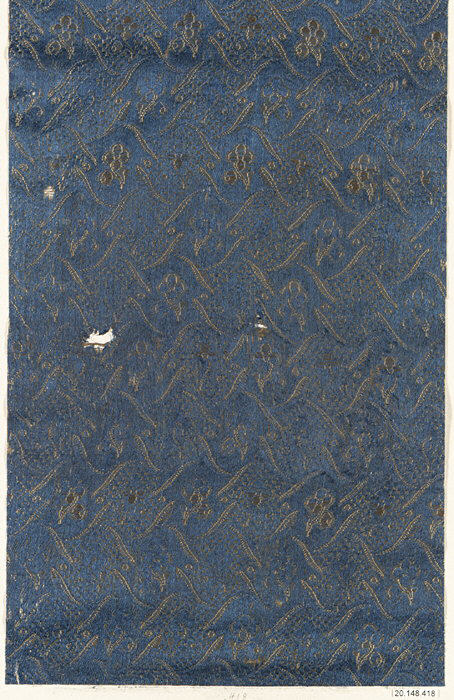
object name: piece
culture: japanese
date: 1701-1800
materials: silk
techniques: compound weave